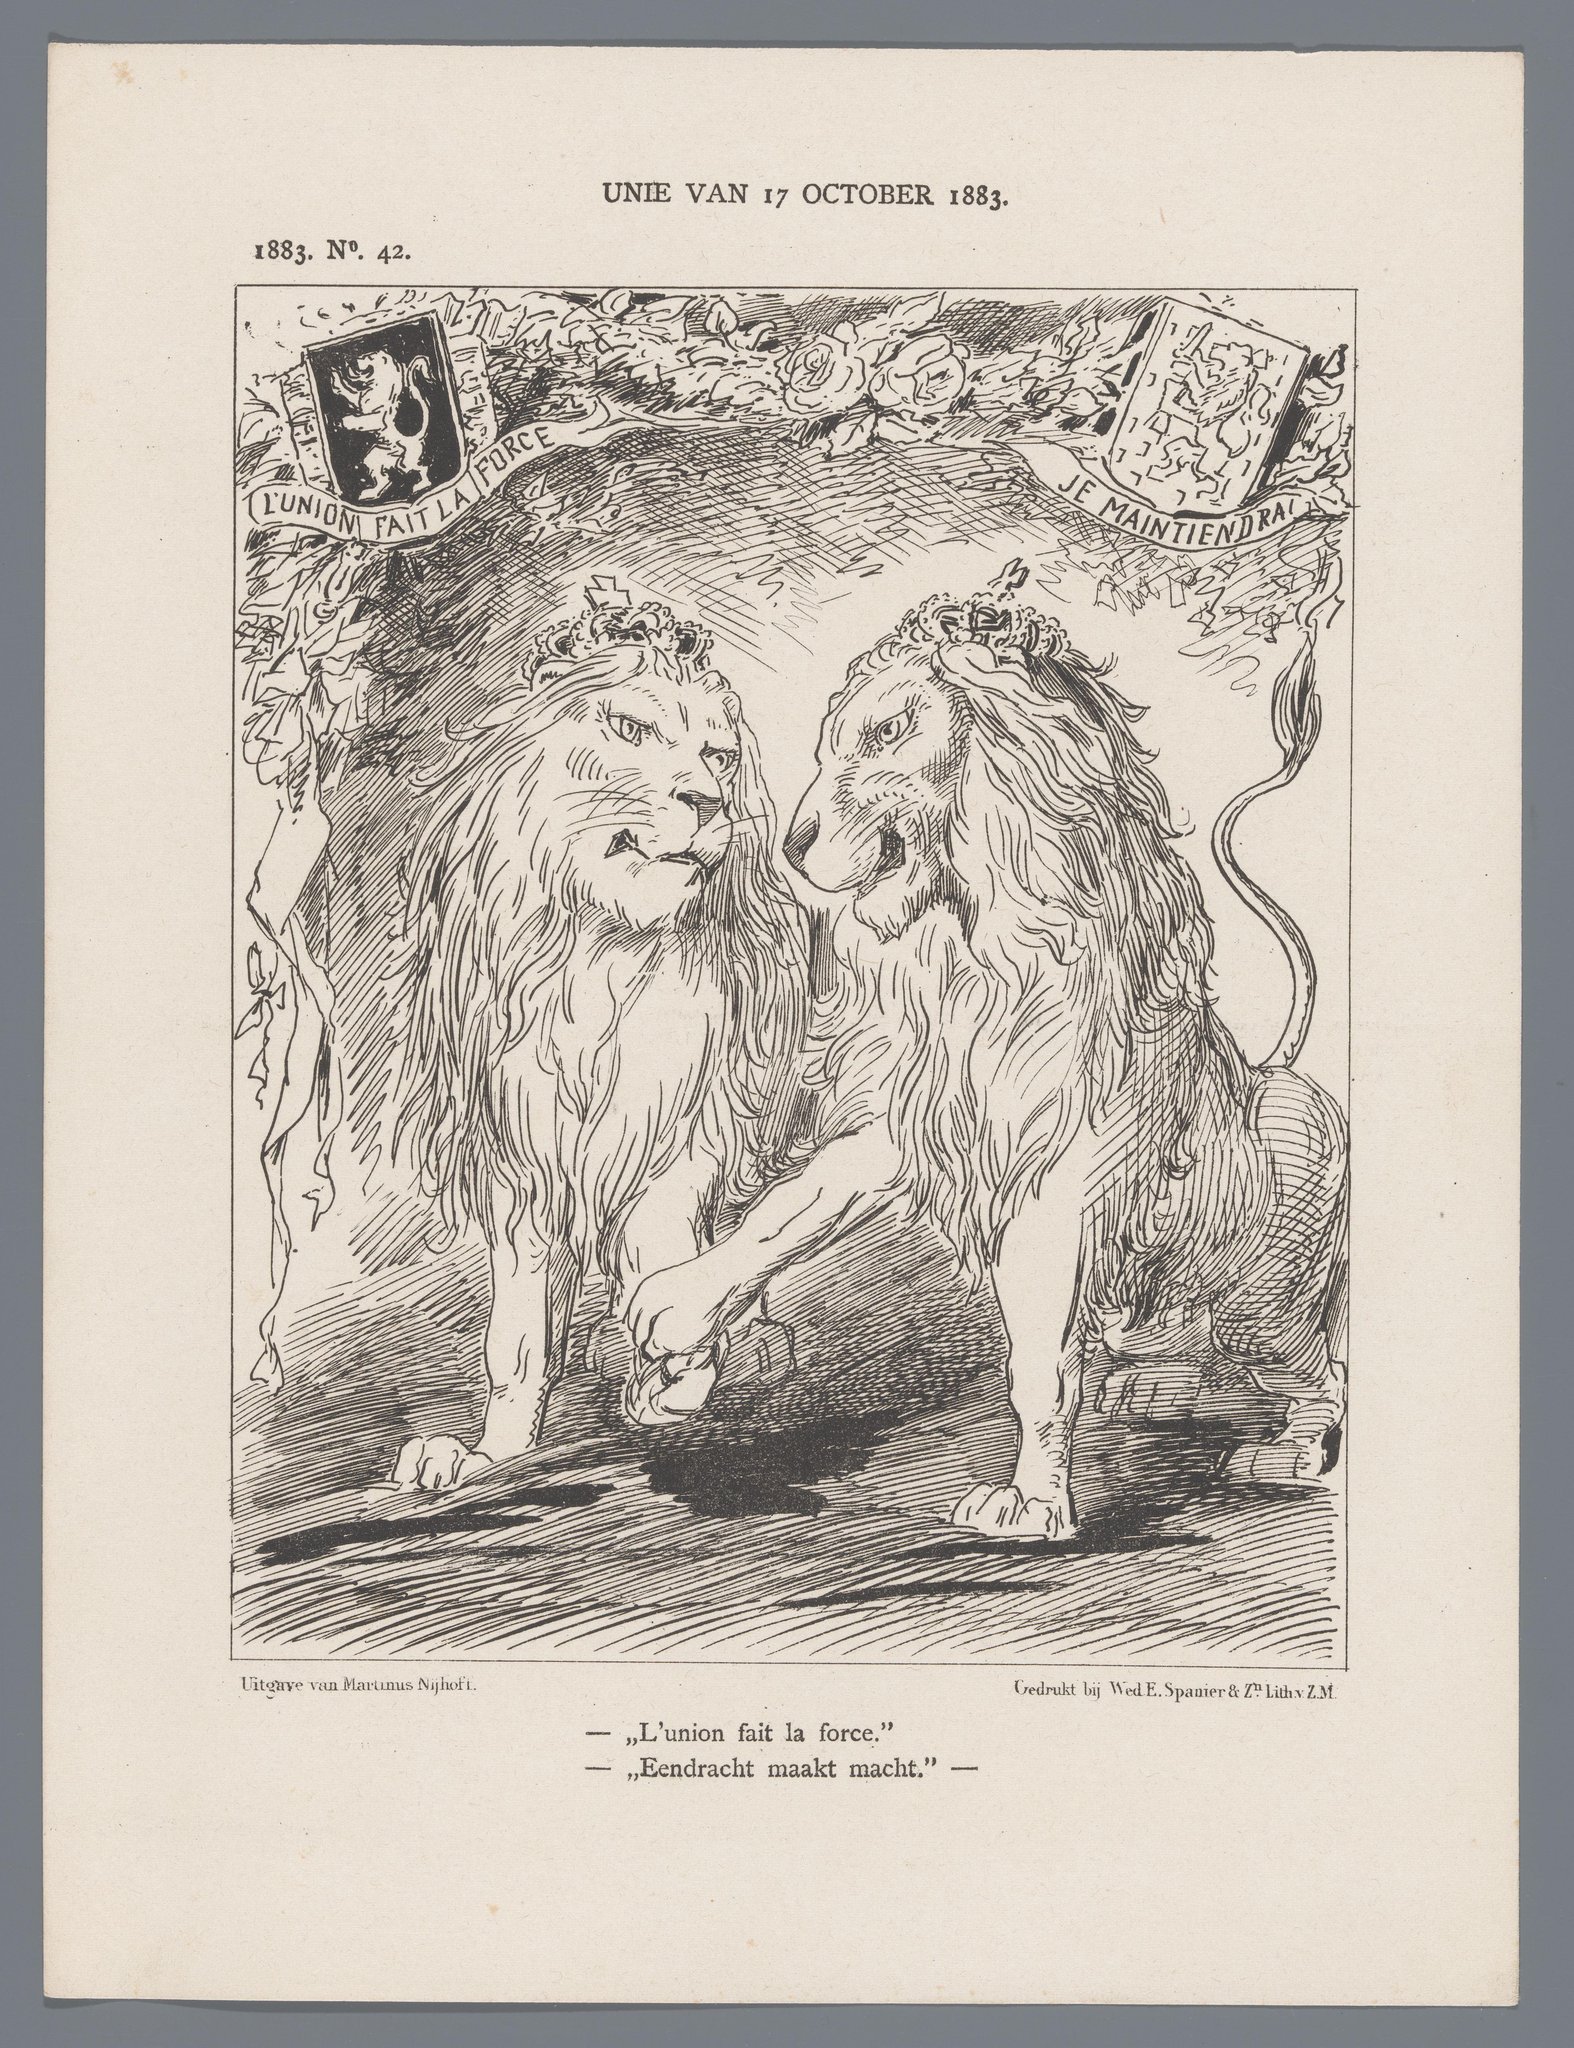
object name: cartoon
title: Unie van 17 October 1883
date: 1883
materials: paper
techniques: lithograph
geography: netherlands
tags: belgium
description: Spotprent over de verbondenheid van Nederland en België, nav de unie van 17 oktober 1883. Eendracht van de Belgische en Nederlandse leeuwen. Plaat verschenen bij het weekblad De Nederlandsche Spectator, nr. 42, 1883.